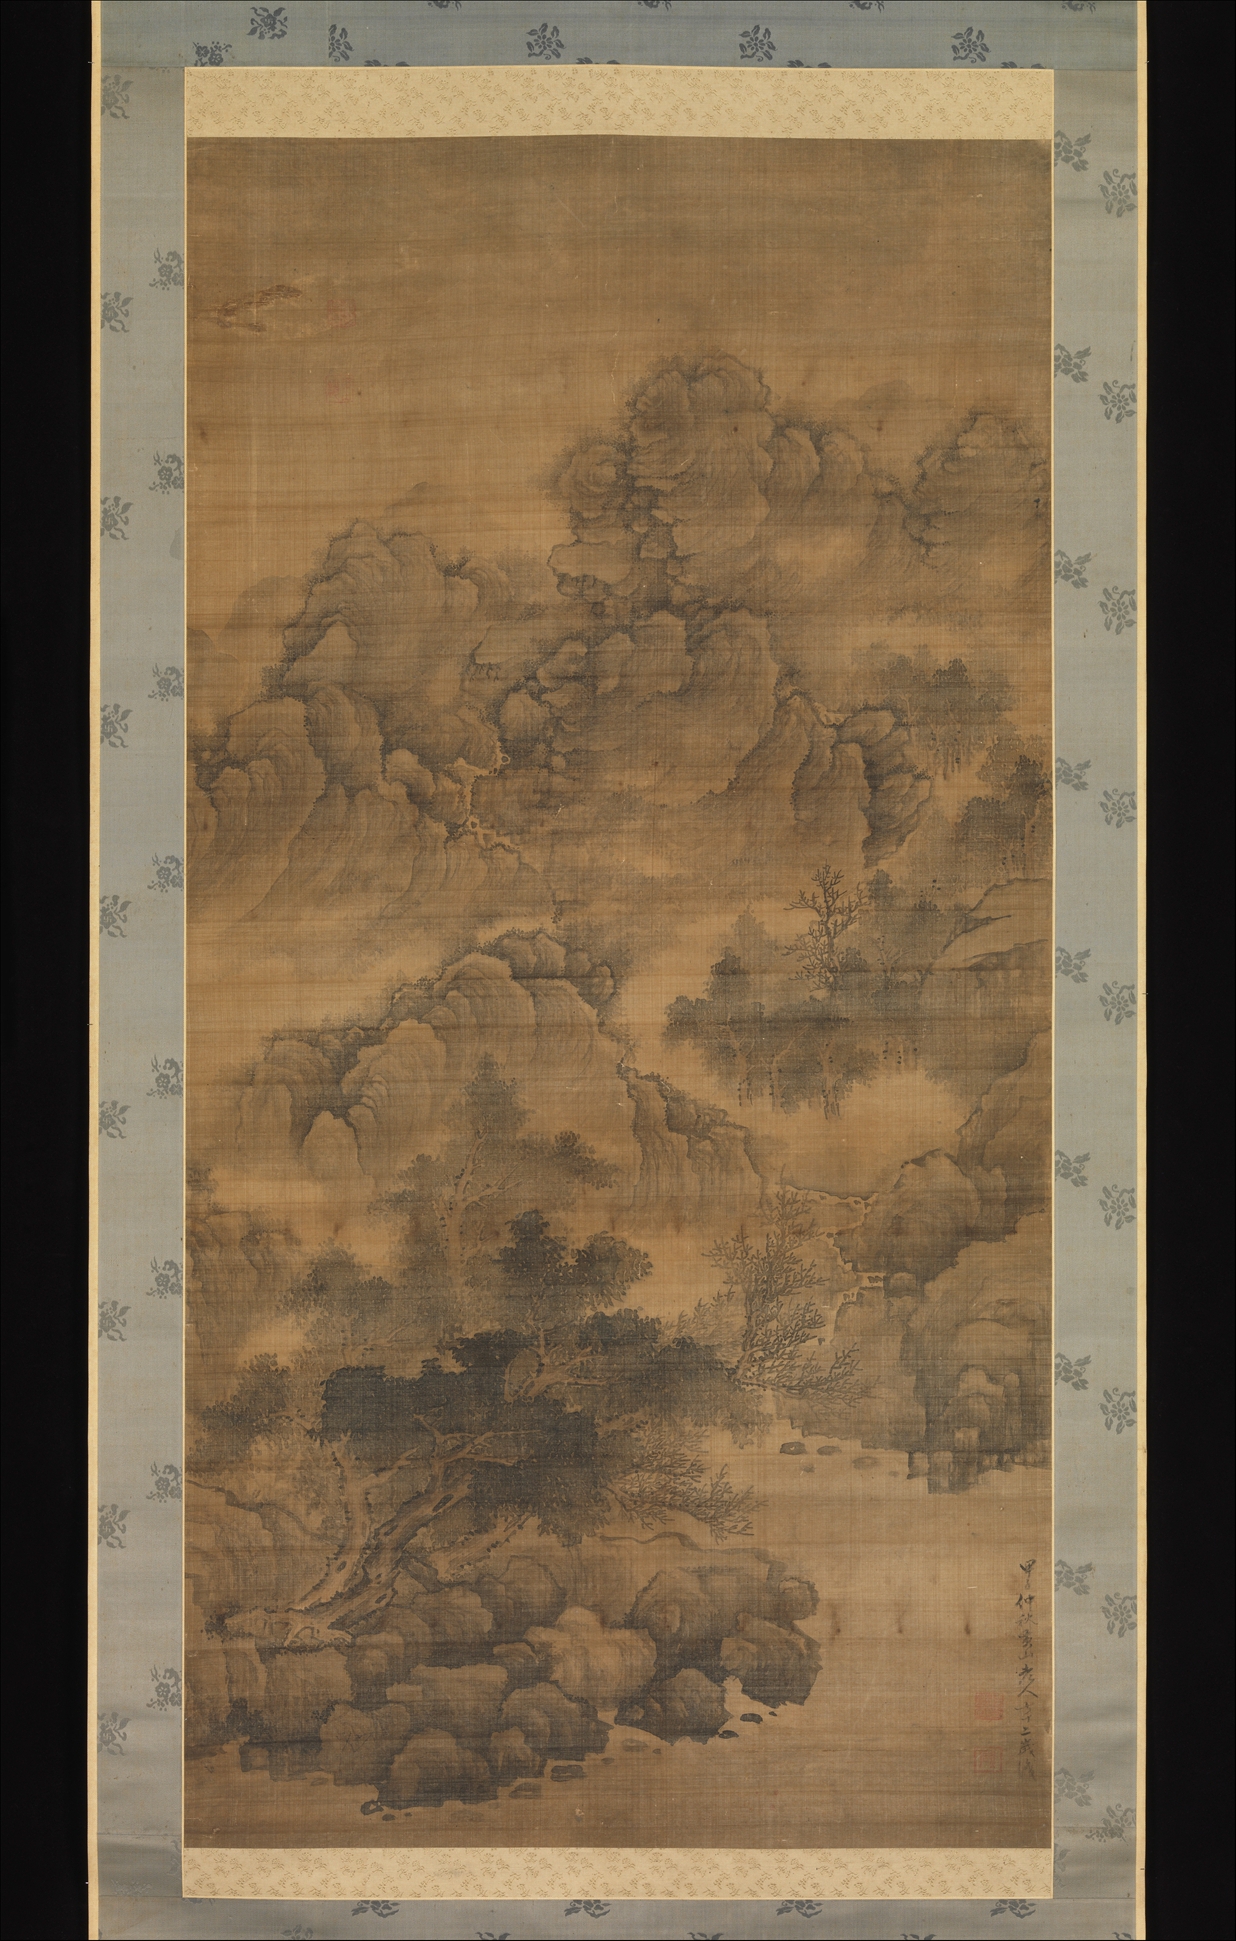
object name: hanging scroll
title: Cloudy mountains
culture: chinese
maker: fa ruozhen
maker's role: artist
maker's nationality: chinese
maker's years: 1613-1696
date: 1684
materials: ink, silk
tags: mountains,landscapes